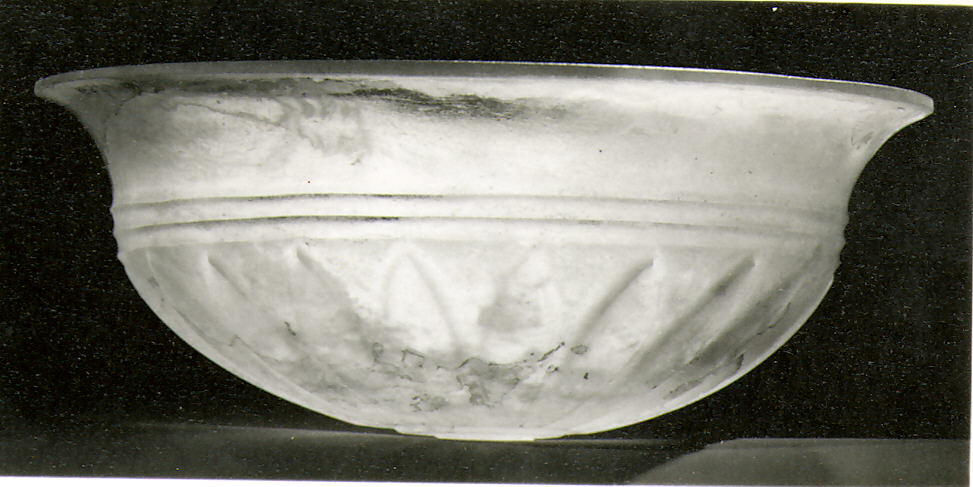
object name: phiale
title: Glass phiale (libation bowl)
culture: greek, eastern mediterranean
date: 434-368 BCE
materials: glass